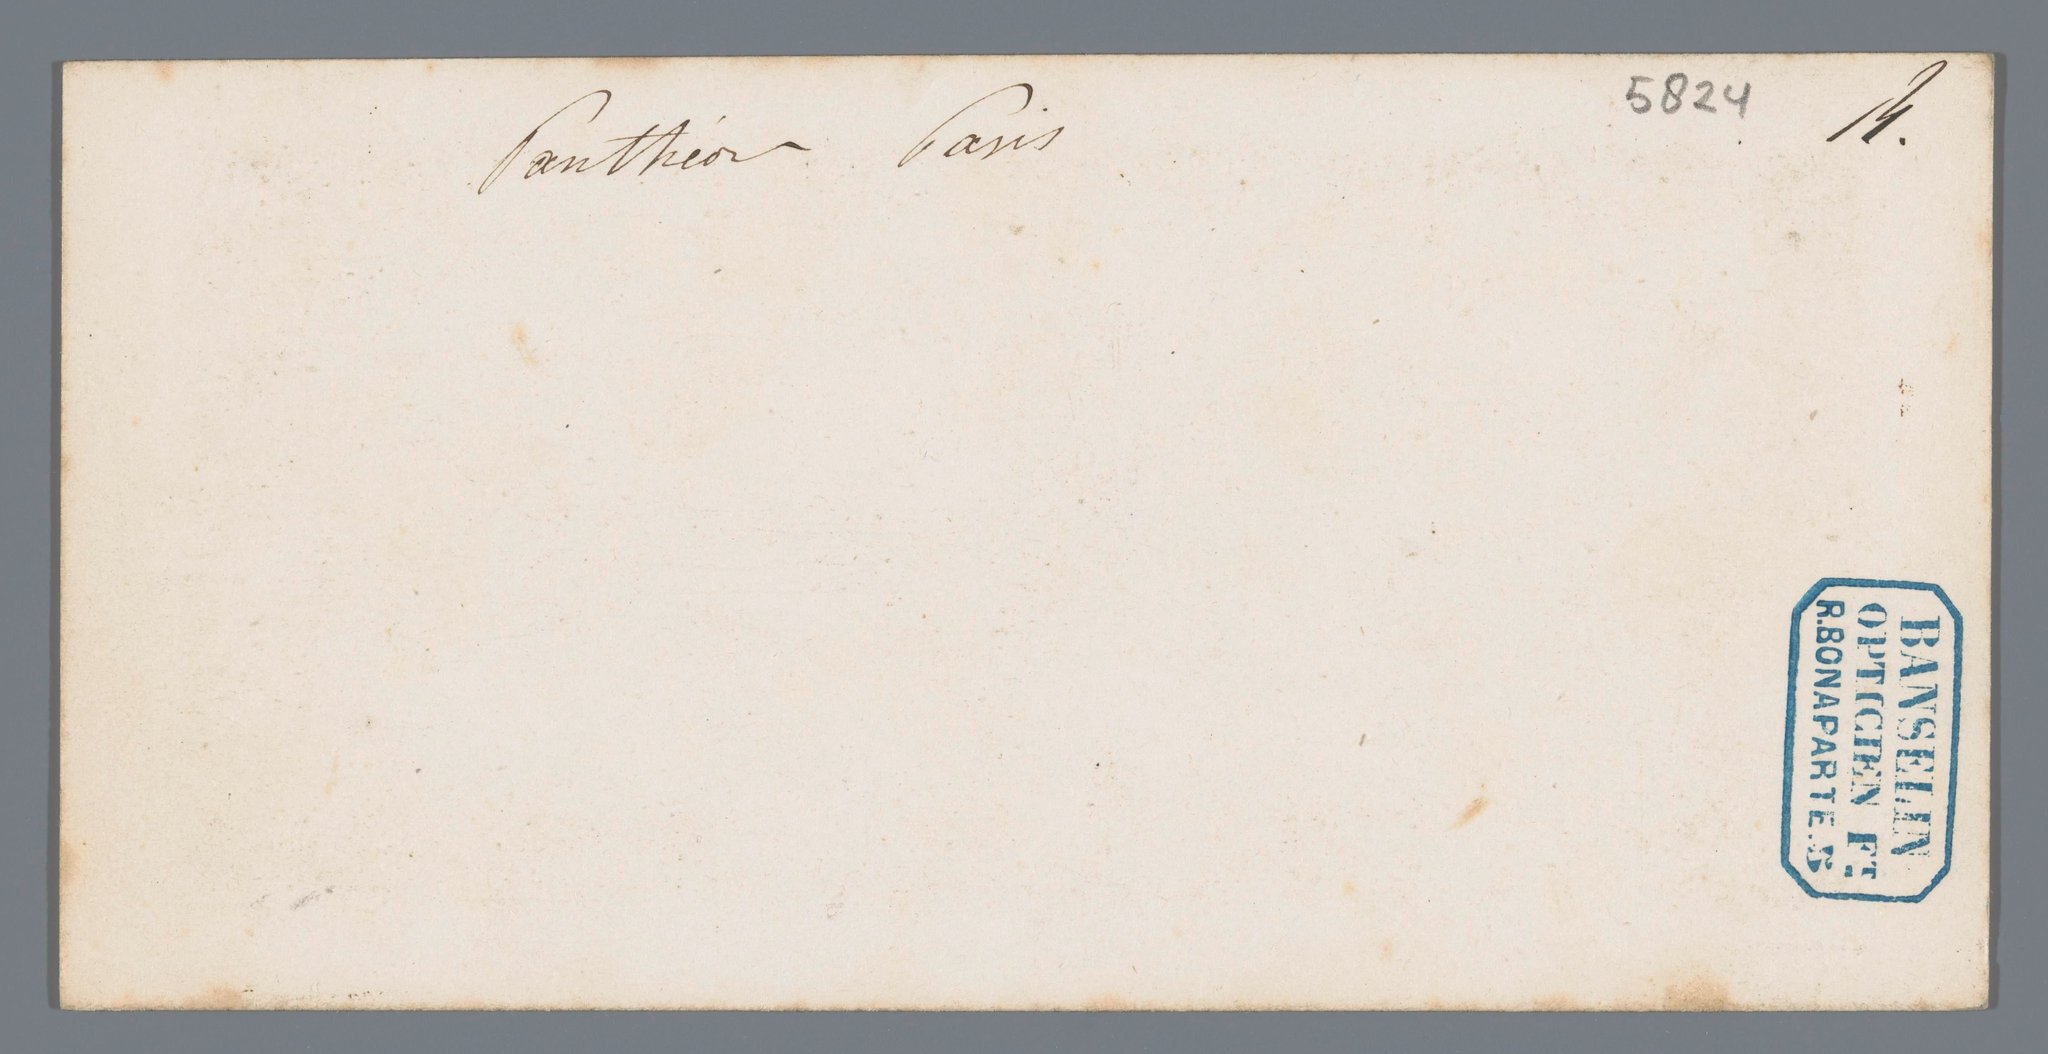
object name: stereograph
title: Gezicht op het Panthéon in Parijs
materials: cardboard, photographic support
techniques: albumen print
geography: paris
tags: dome ~ architecture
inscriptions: number: ‘14.’, monogram: ‘N.P.C.’, inscription: ‘Panthéon Paris’